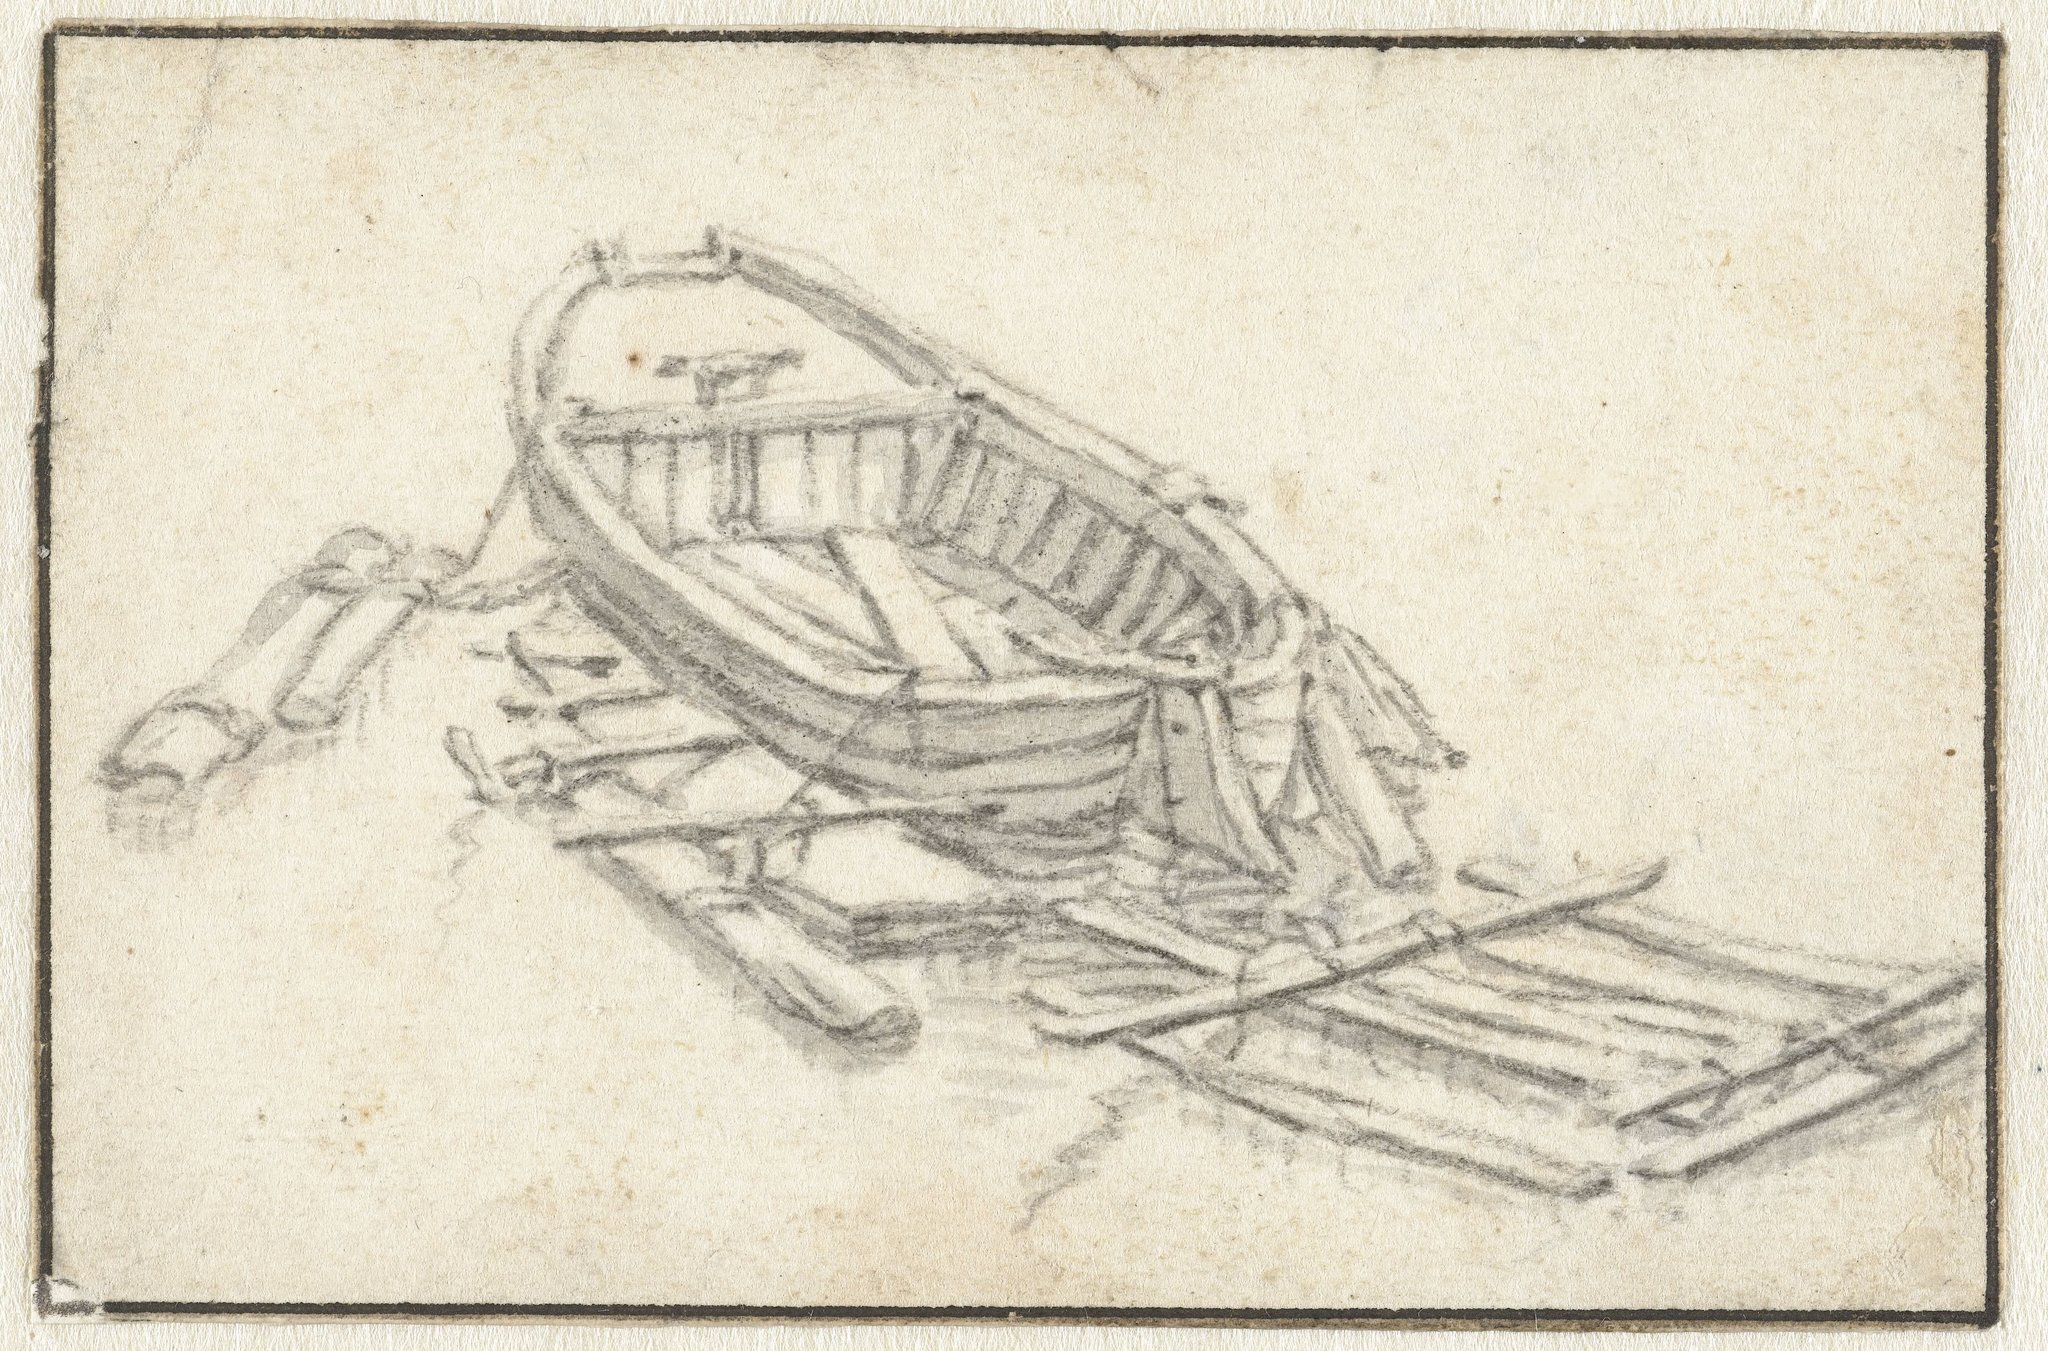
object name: drawing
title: Leeg bootje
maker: herman saftleven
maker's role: draughtsman, painter, print maker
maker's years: 1609-1685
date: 1619-1685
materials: chalk, paper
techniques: brush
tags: oaring, sculling